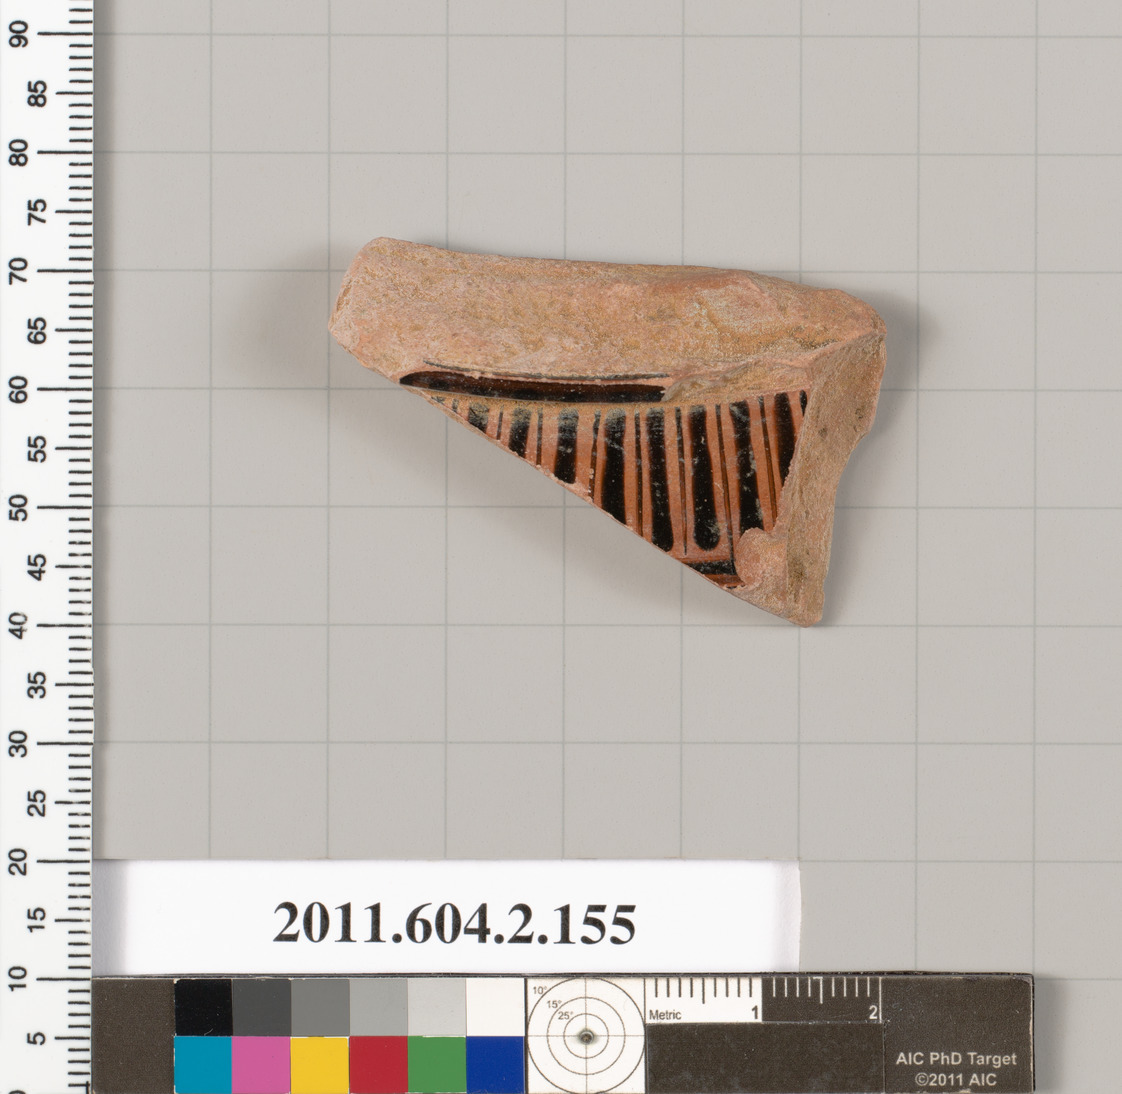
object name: stamnos fragment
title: Terracotta fragment of a stamnos (jar)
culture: greek, attic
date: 470-450 BCE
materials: terracotta